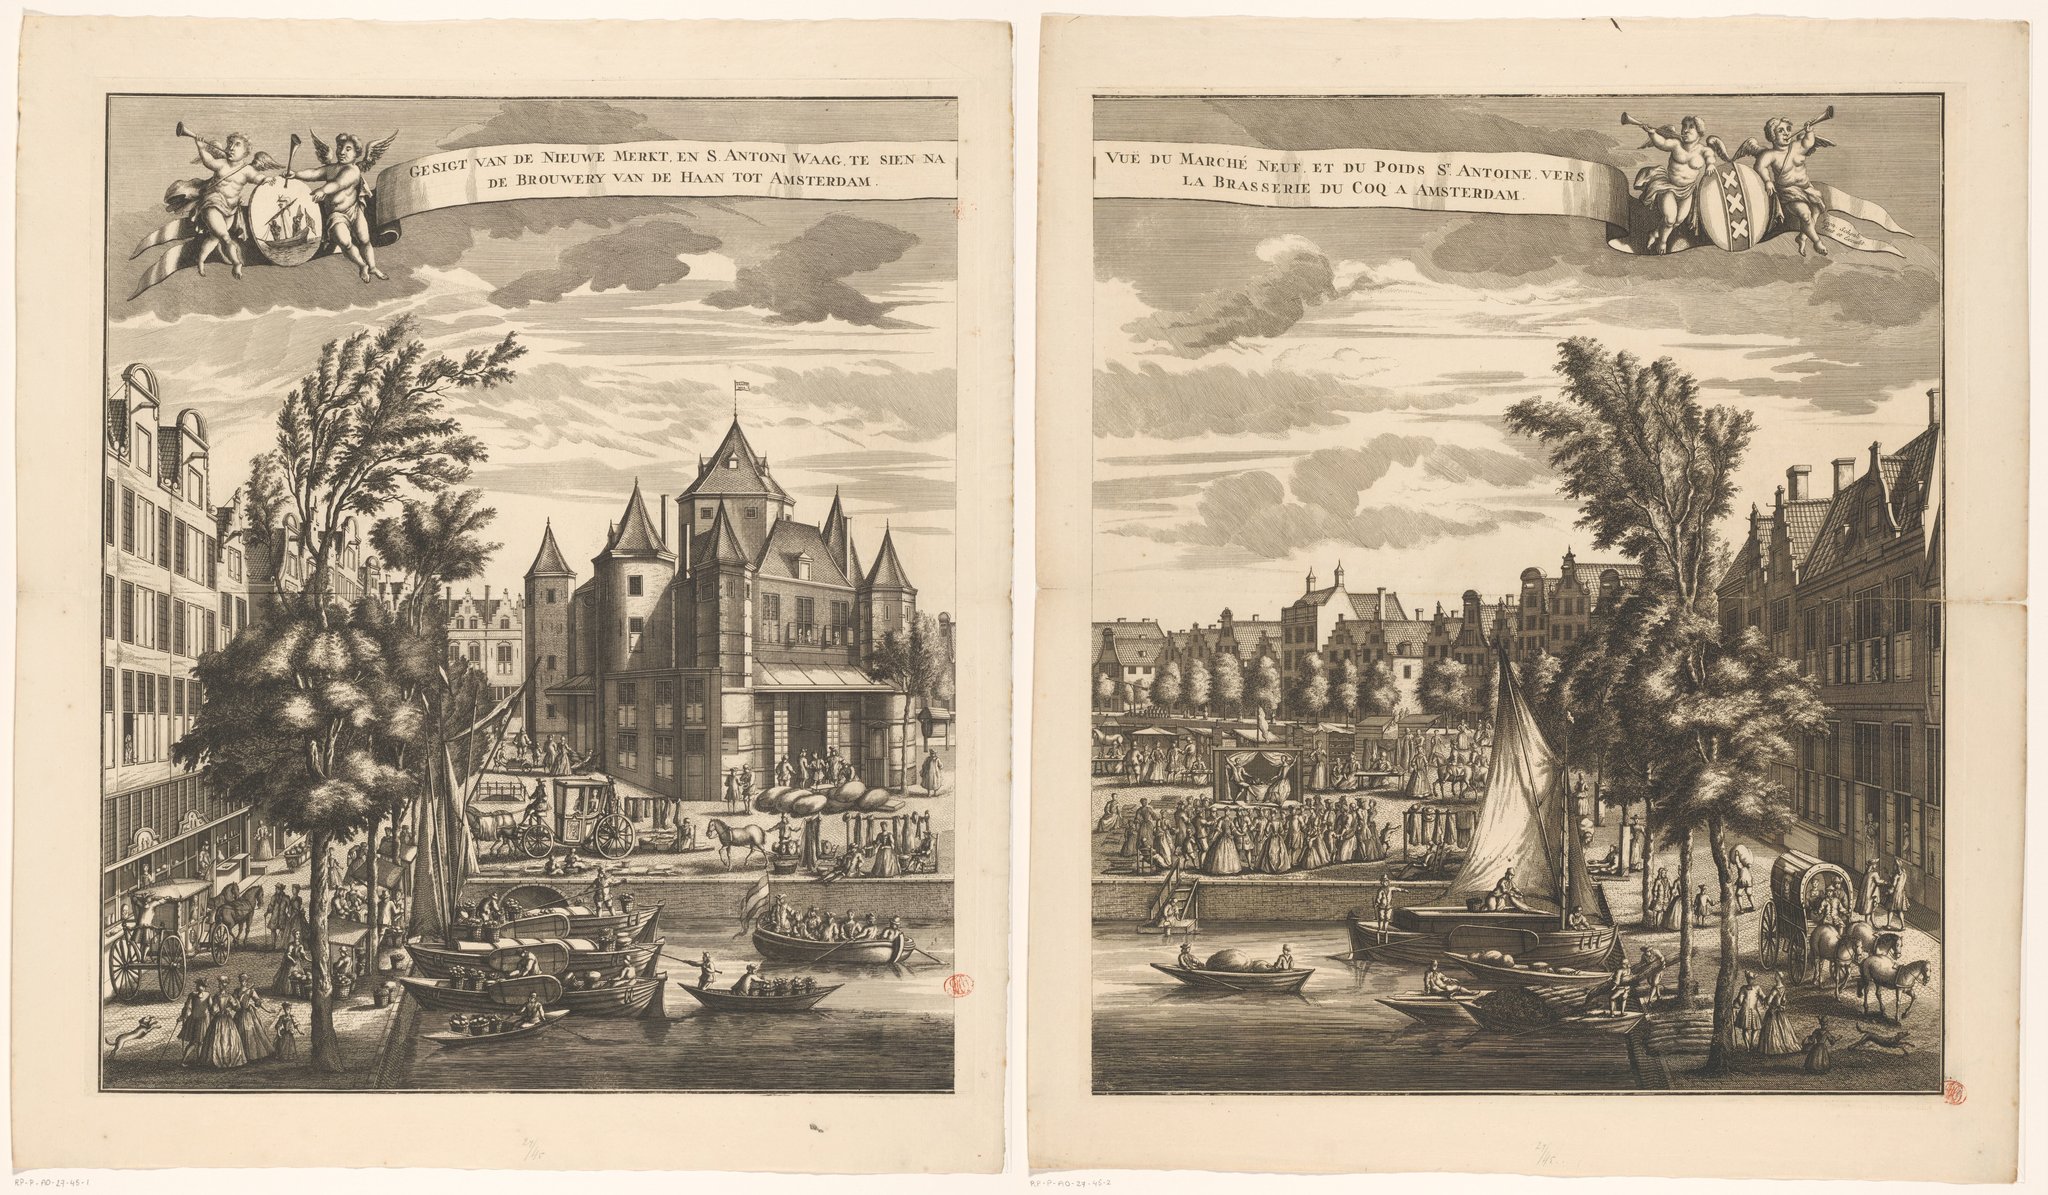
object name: print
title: Gezicht op de Nieuwmarkt te Amsterdam, bestaande uit twee delen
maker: leonard schenk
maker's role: print maker, publisher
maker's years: 1696-1767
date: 1710-1767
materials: paper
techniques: engraving, etching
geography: amsterdam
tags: buildings for performances - aa - open-air performances, coat of arms (as symbol of the state, etc.) (+ city; municipal), seal (as symbol of the state, etc.) (+ city; municipal), stalls ~ theatre, etc. - aa - open-air performances, stall, booth (~ market), ships (in general) - cc - more than one ship, market, weigh-house, square, place, circus, etc. (+ city(-scape) with figures, staffage), canals, waters (in city) (+ city(-scape) with figures, staffage), street (+ city(-scape) with figures, staffage)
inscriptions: collector's mark: Lugt 195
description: Gezicht op de Nieuwmarkt (Sint-Antoniesmarkt) te Amsterdam, gezien vanaf de Kloveniersburgwal. Links van het midden de Waag op de Nieuwmarkt, ook wel bekend als de Sint-Antonieswaag. Deze waag was gevestigd in de voormalige vijftiende-eeuwse Eerste Sint-Antoniespoort. Op en om de markt vele figuren en veel bedrijvigheid. Marktlui bieden allerlei koopwaar aan. Rechts van het midden wordt op een podium in openlucht een voorstelling gegeven. Langs de bovenkant een banderol met de titel. Links daarvan twee putti met het stadszegel, rechts twee putti met het wapen van de stad.